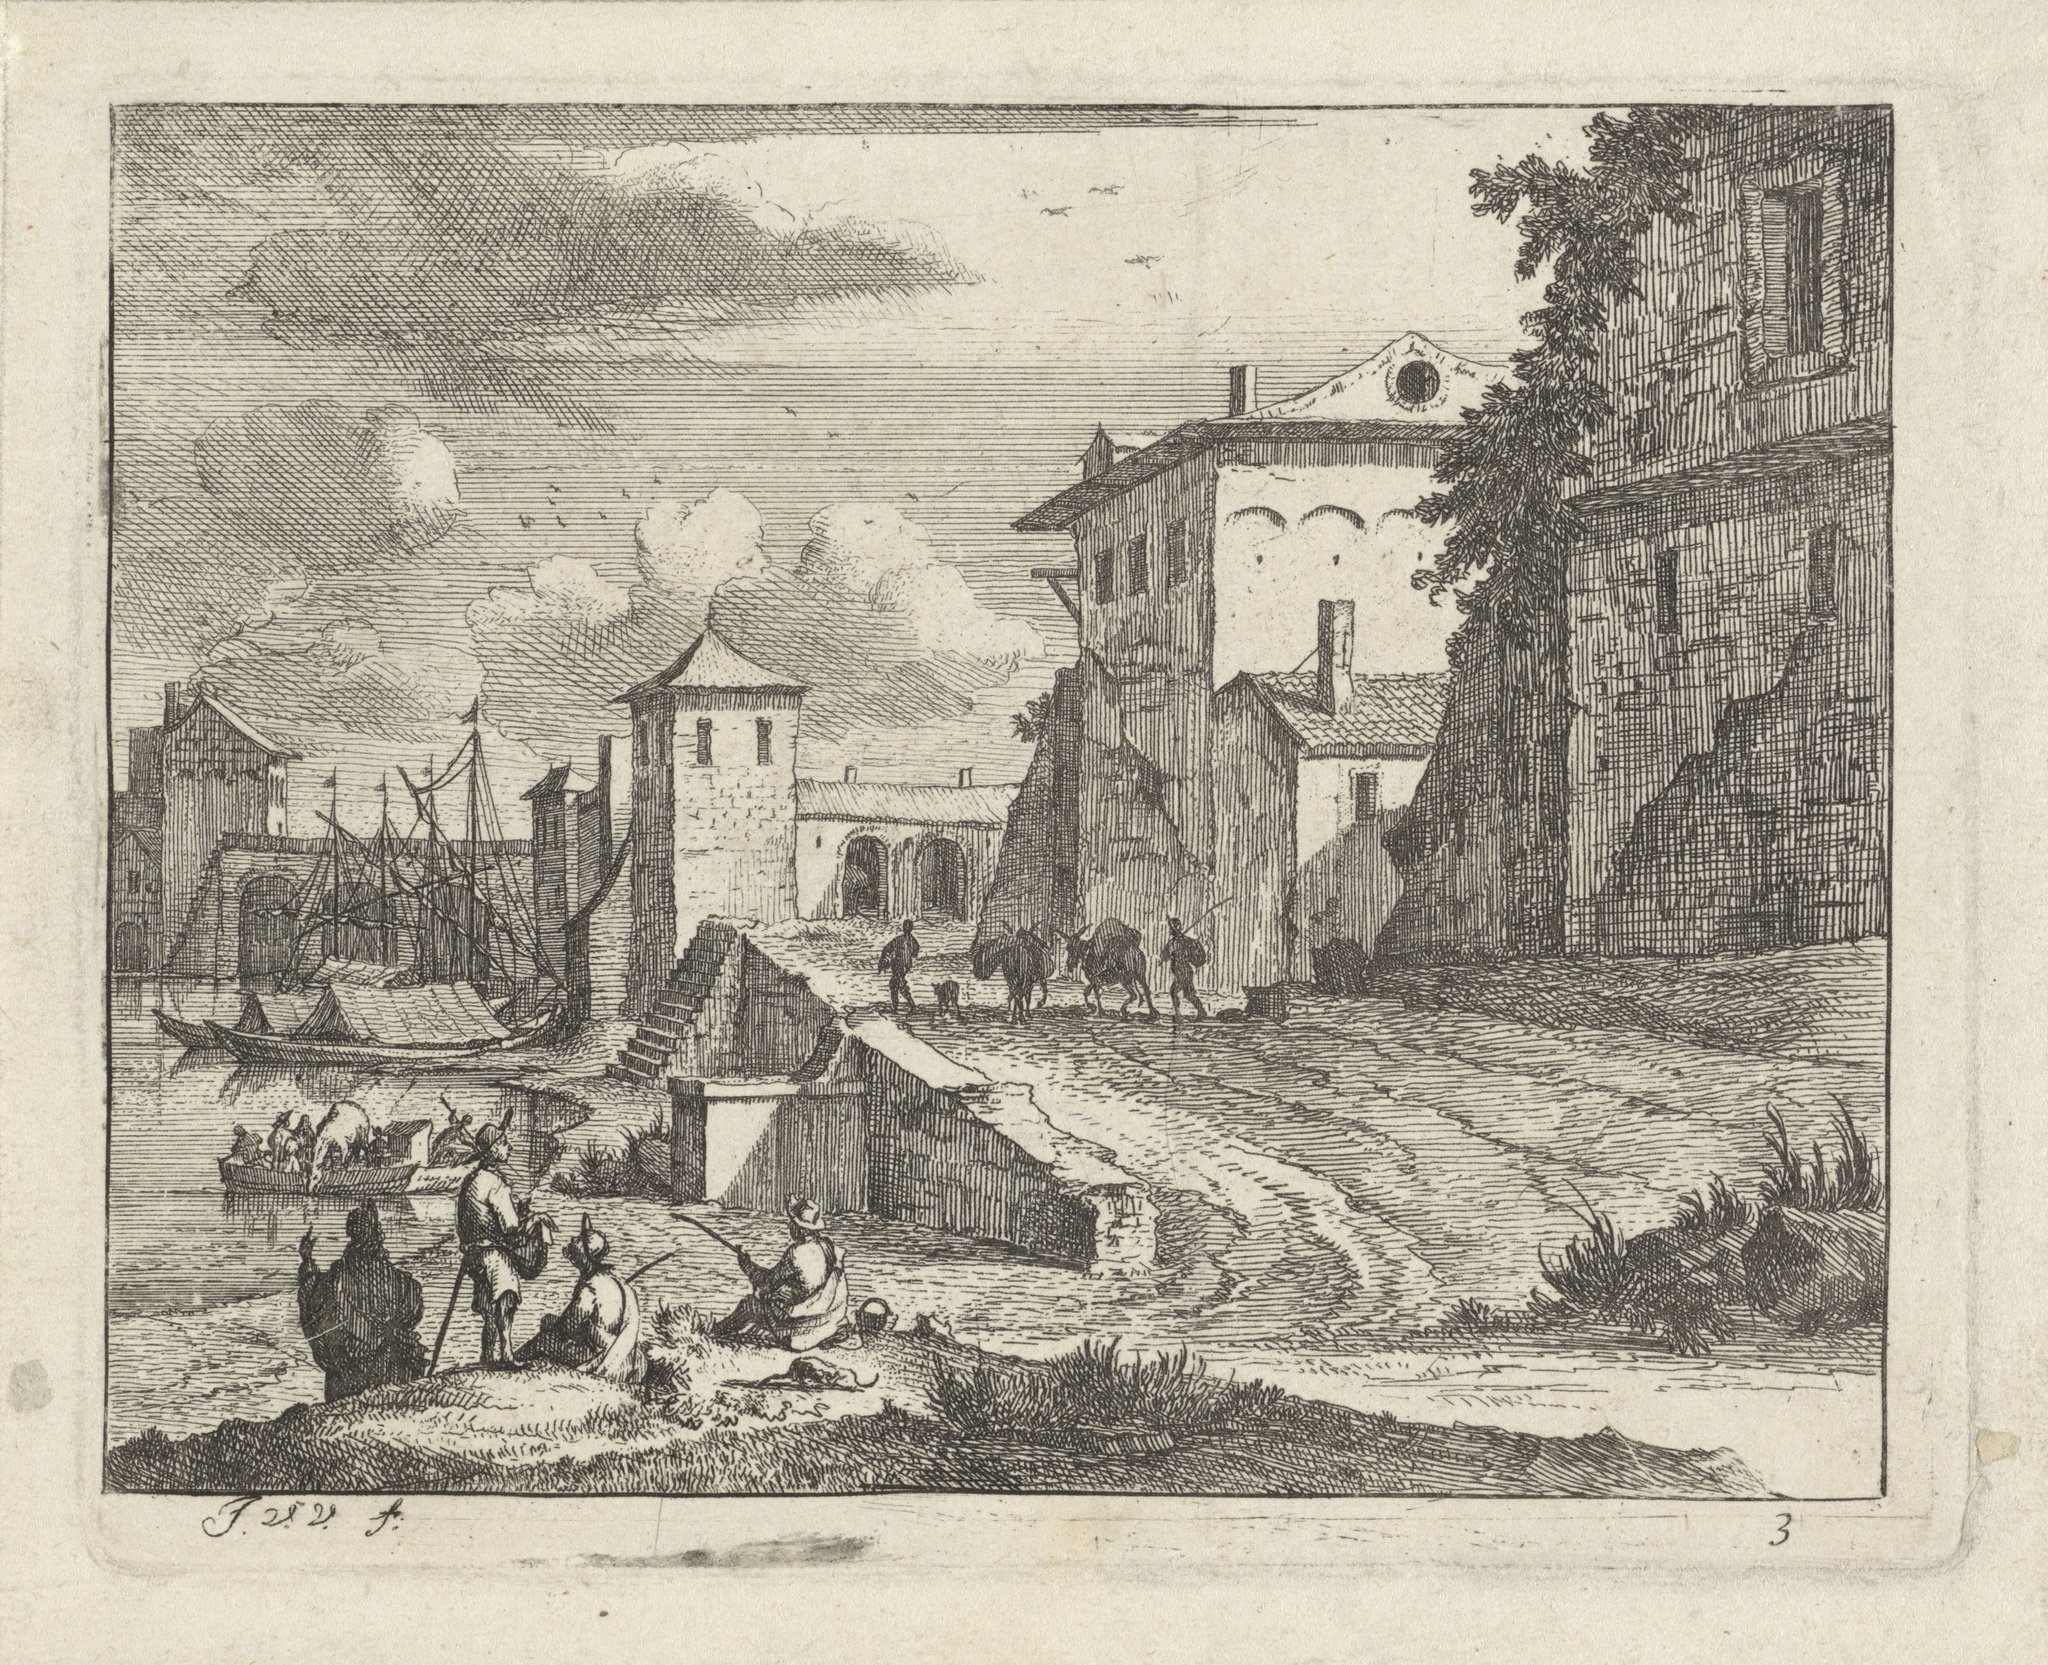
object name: print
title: Gezicht op een havenplaats, C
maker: thomas wijck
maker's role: draughtsman, painter, print maker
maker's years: 1616-1677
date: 1686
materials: paper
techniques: etching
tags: harbour, towers ~ fortified city, ferry, city-walls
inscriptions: collector's mark: Lugt 2228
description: Gezicht op een havenplaats. Vier conserverende figuren op de voorgrond. Op de weg langs huizen twee figuren met ezels en een hond. Op het water een veerboot.